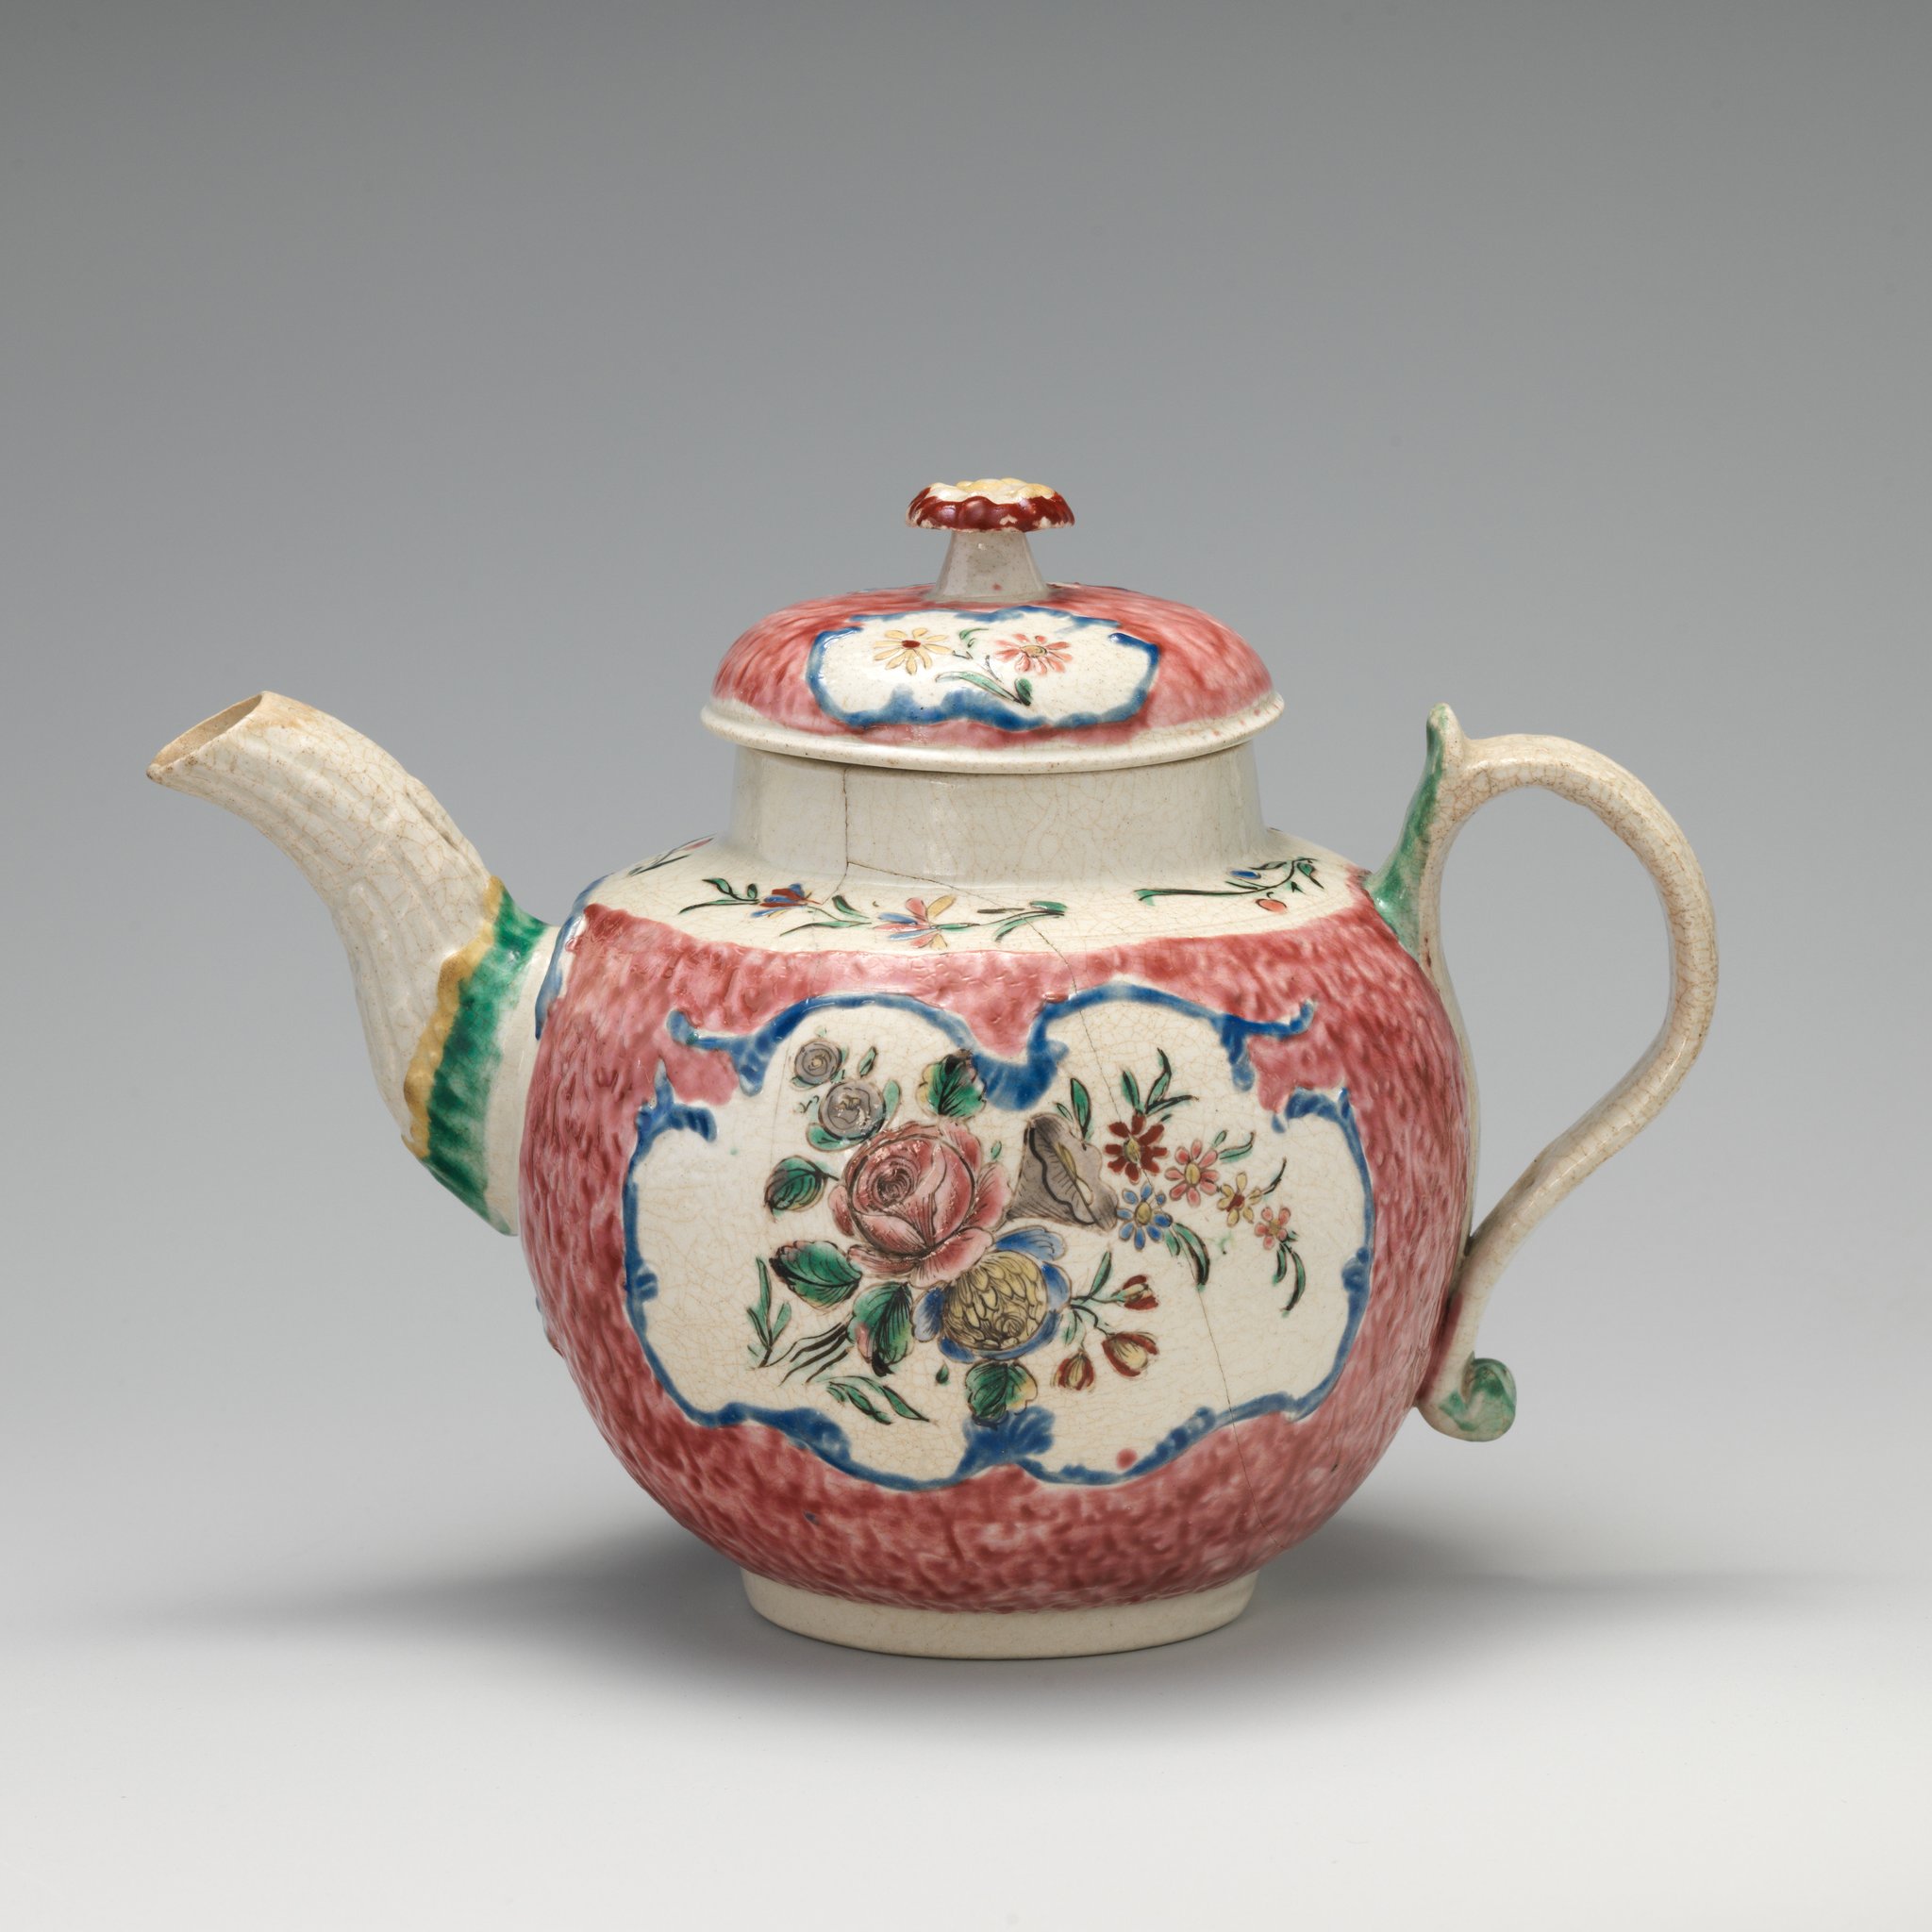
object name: teapot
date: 1765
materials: stoneware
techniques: salt glaze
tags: flowers